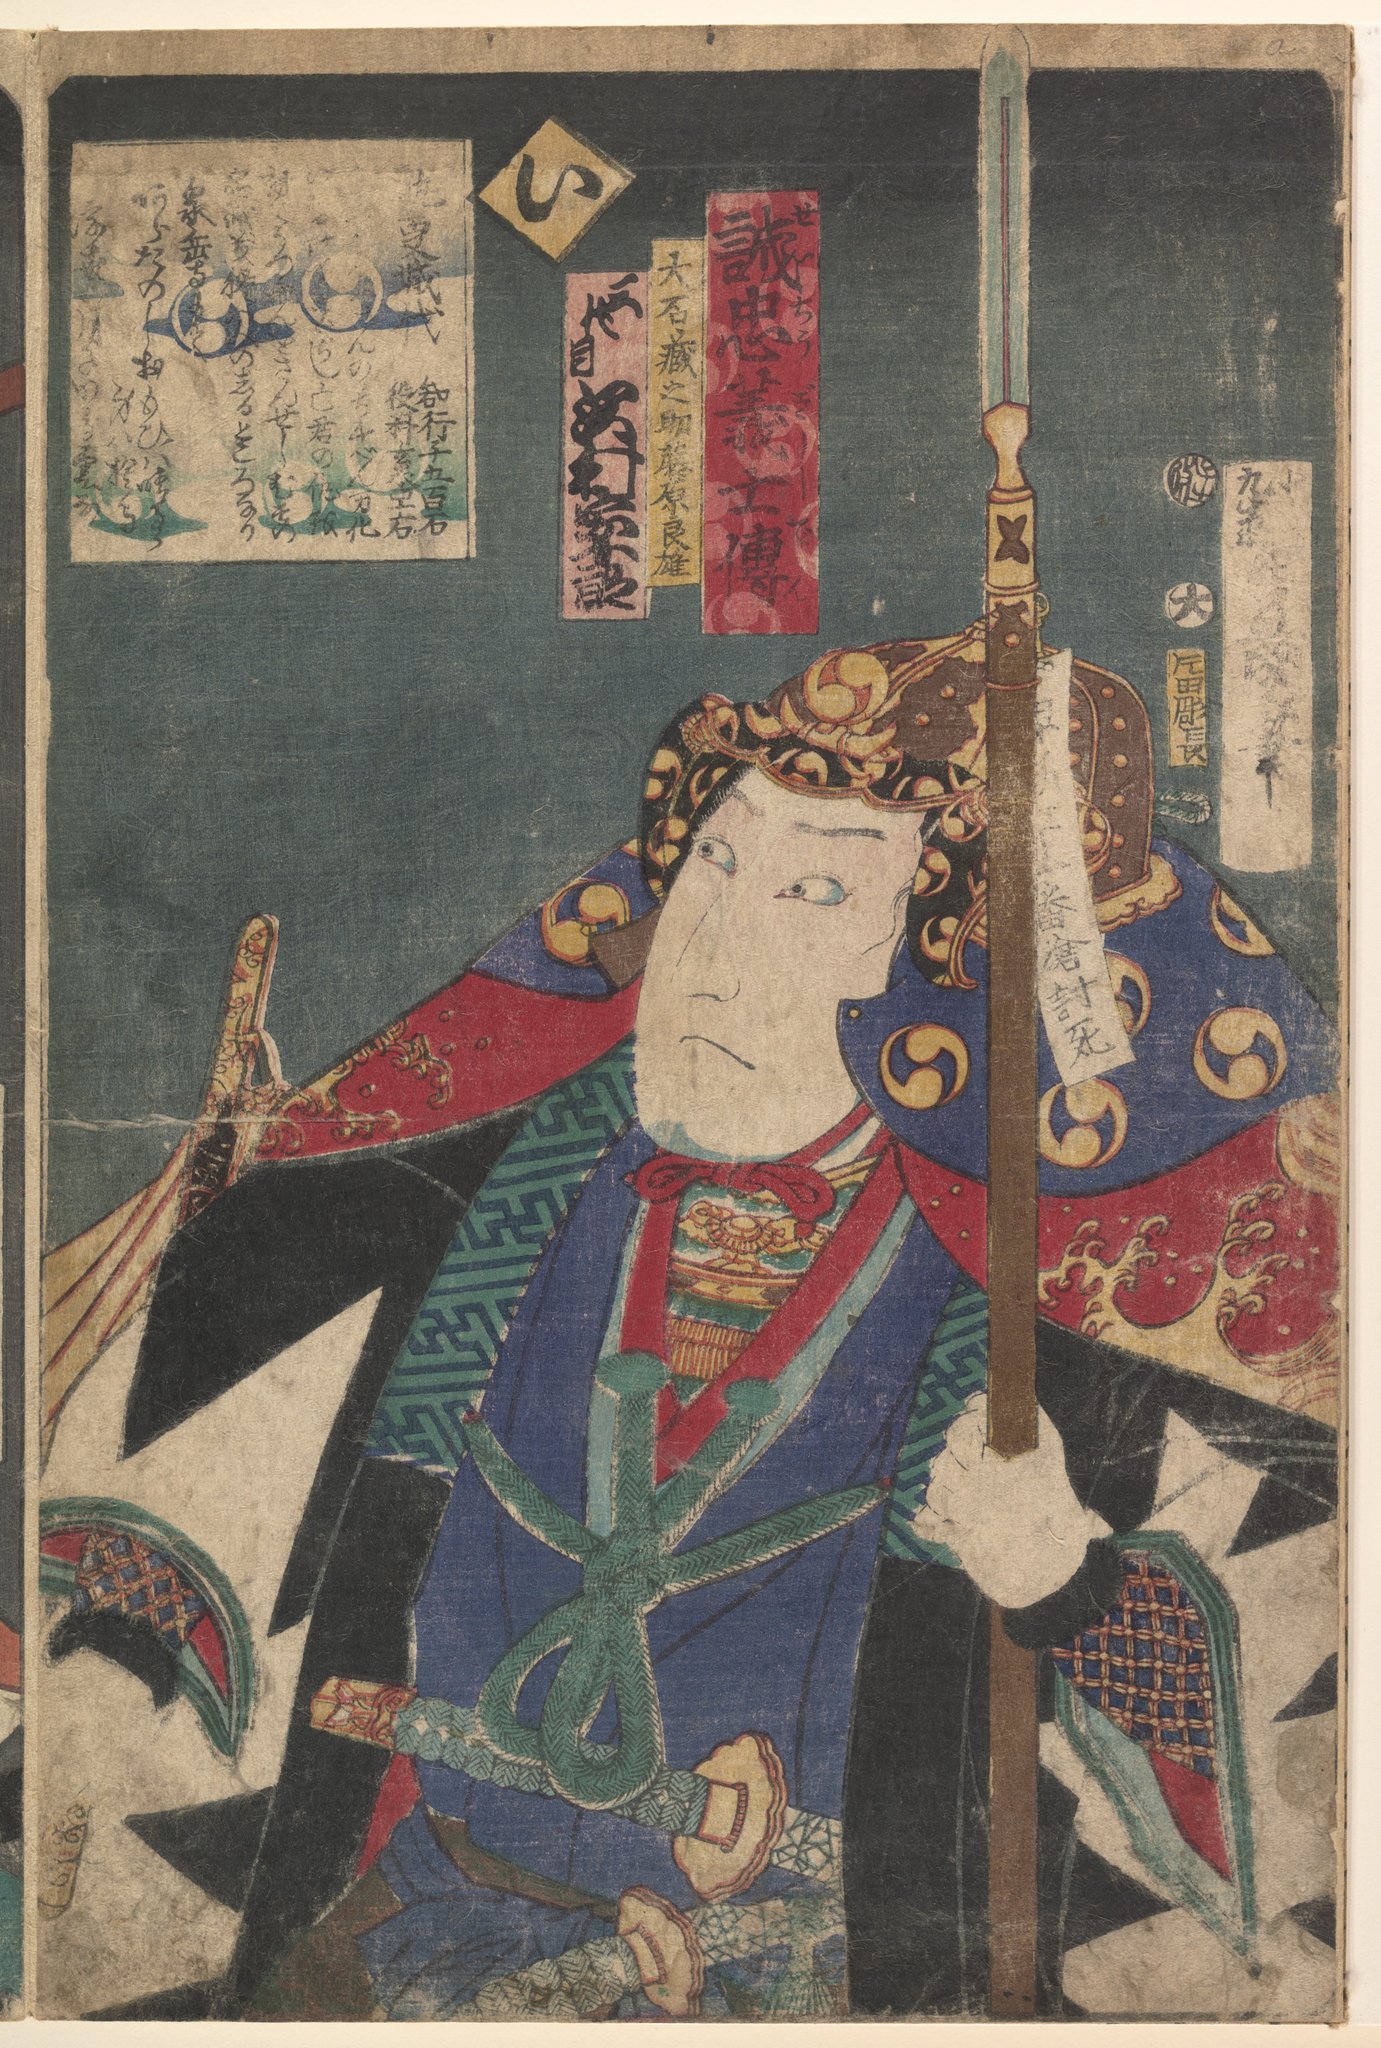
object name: print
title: Kabuki actors play the role of 47 Ronin (Seichū gishi den)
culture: japanese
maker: utagawa kunisada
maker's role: artist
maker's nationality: japanese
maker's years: 1786-1864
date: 1769-1900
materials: ink, paper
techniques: woodblock print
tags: spears,swords,men,actors